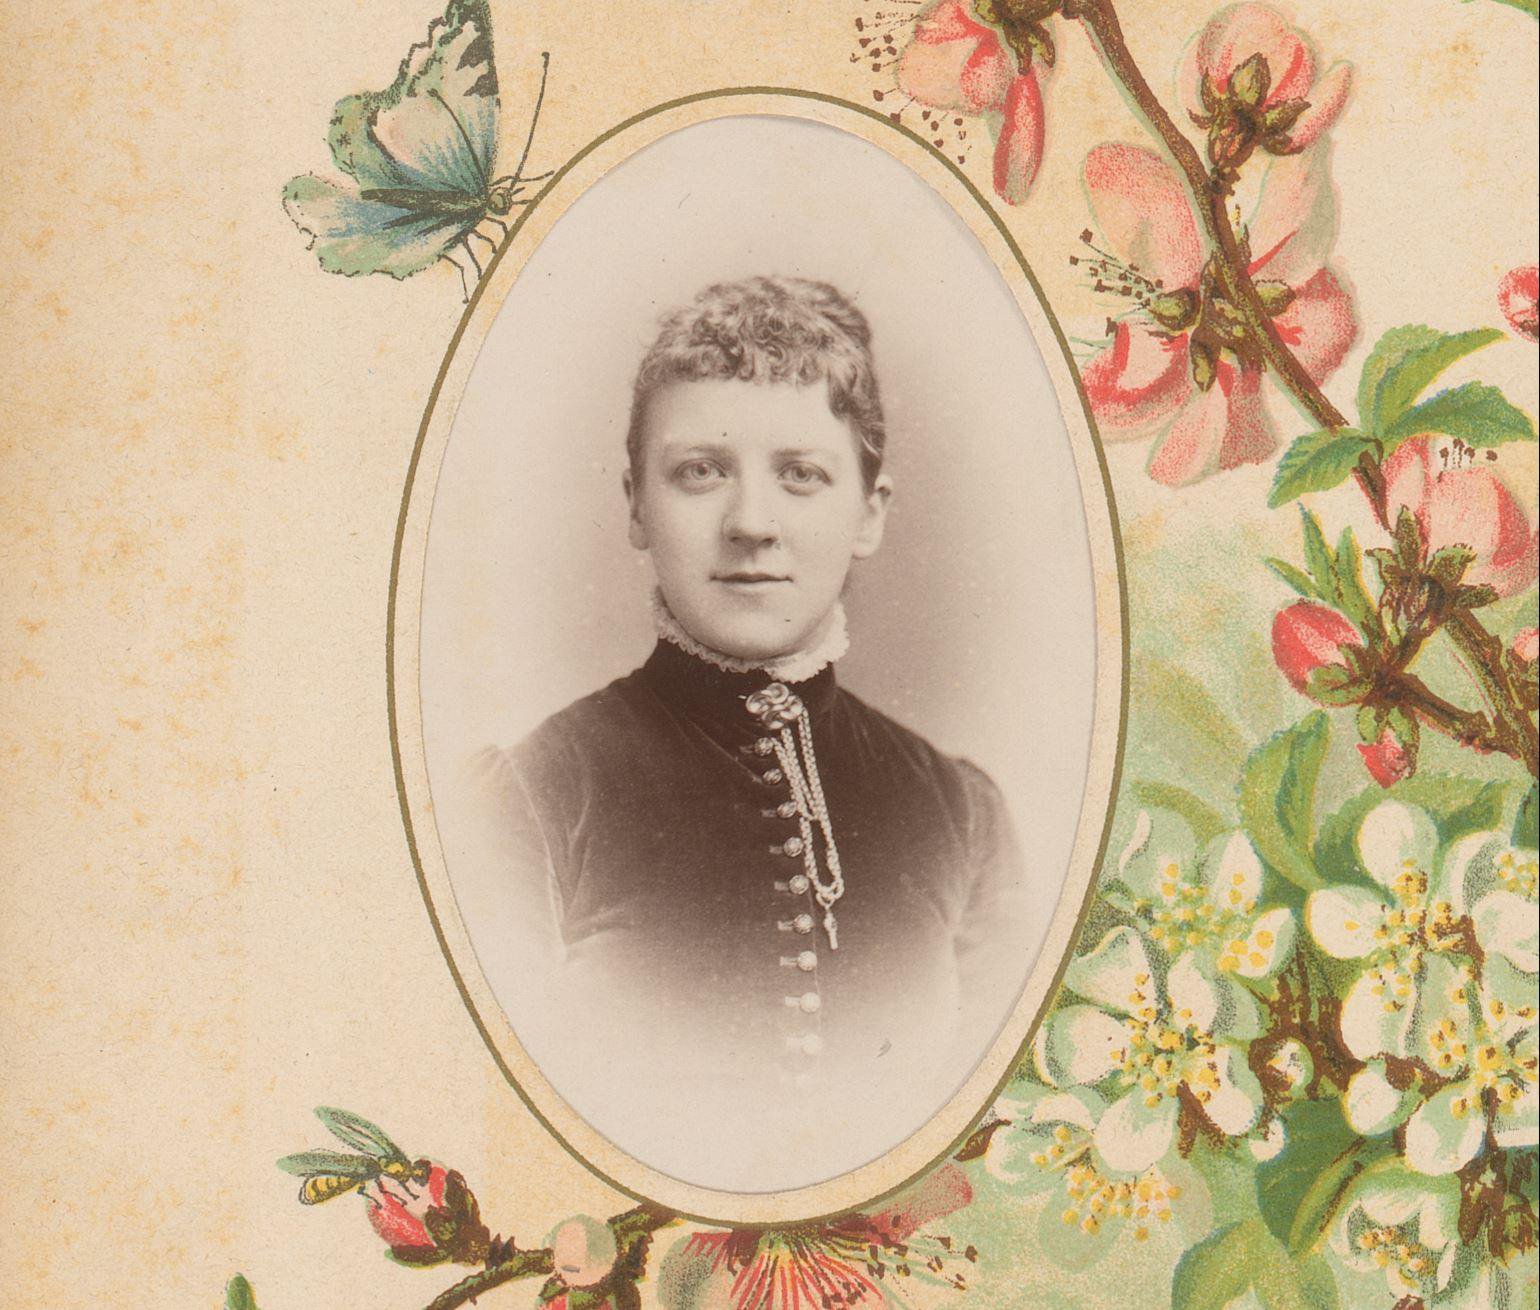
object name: album leaf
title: Portret van een vrouw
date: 1860-1900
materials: cardboard, photographic support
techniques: albumen print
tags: adult man, historical persons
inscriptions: inscription: ‘Artist/ Photographers/ Lowthian Bros/ Art Studio/ GRimsby/ (...)’